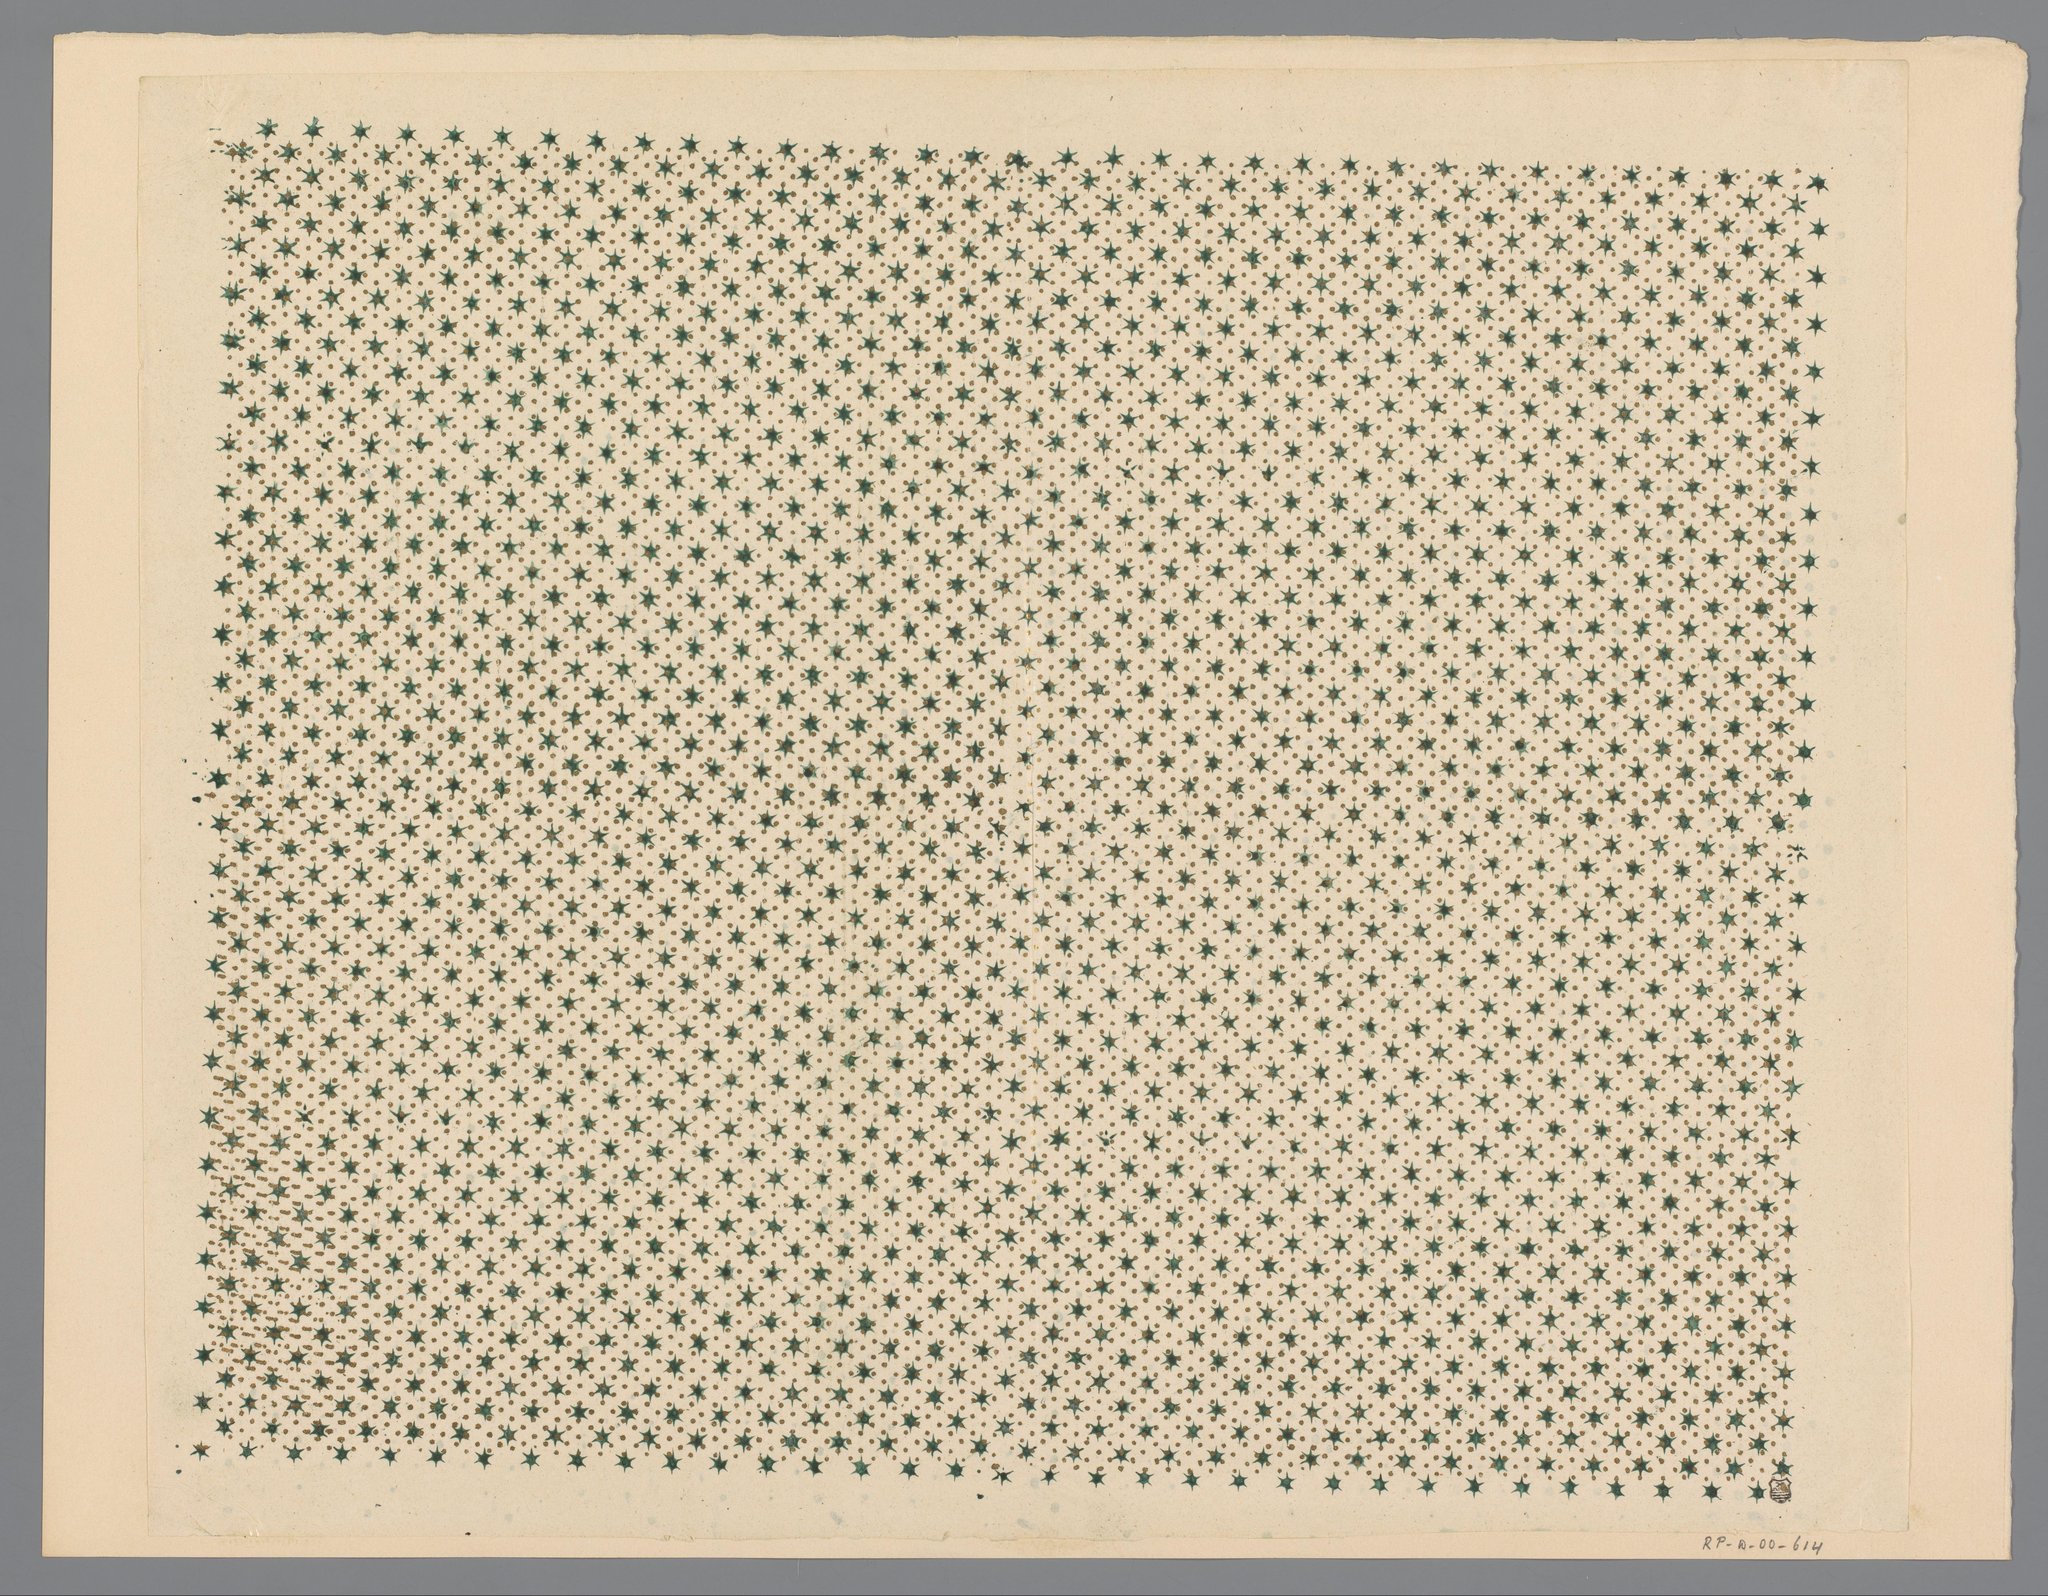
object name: printed paper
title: Blad met strooipatronen van sterren en stippen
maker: Anonymous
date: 1800-1900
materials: paint, paper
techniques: printing block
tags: ornament ~ starforms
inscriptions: collector's mark: Lugt 2760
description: Blad met strooipatronen van sterren en stippen.